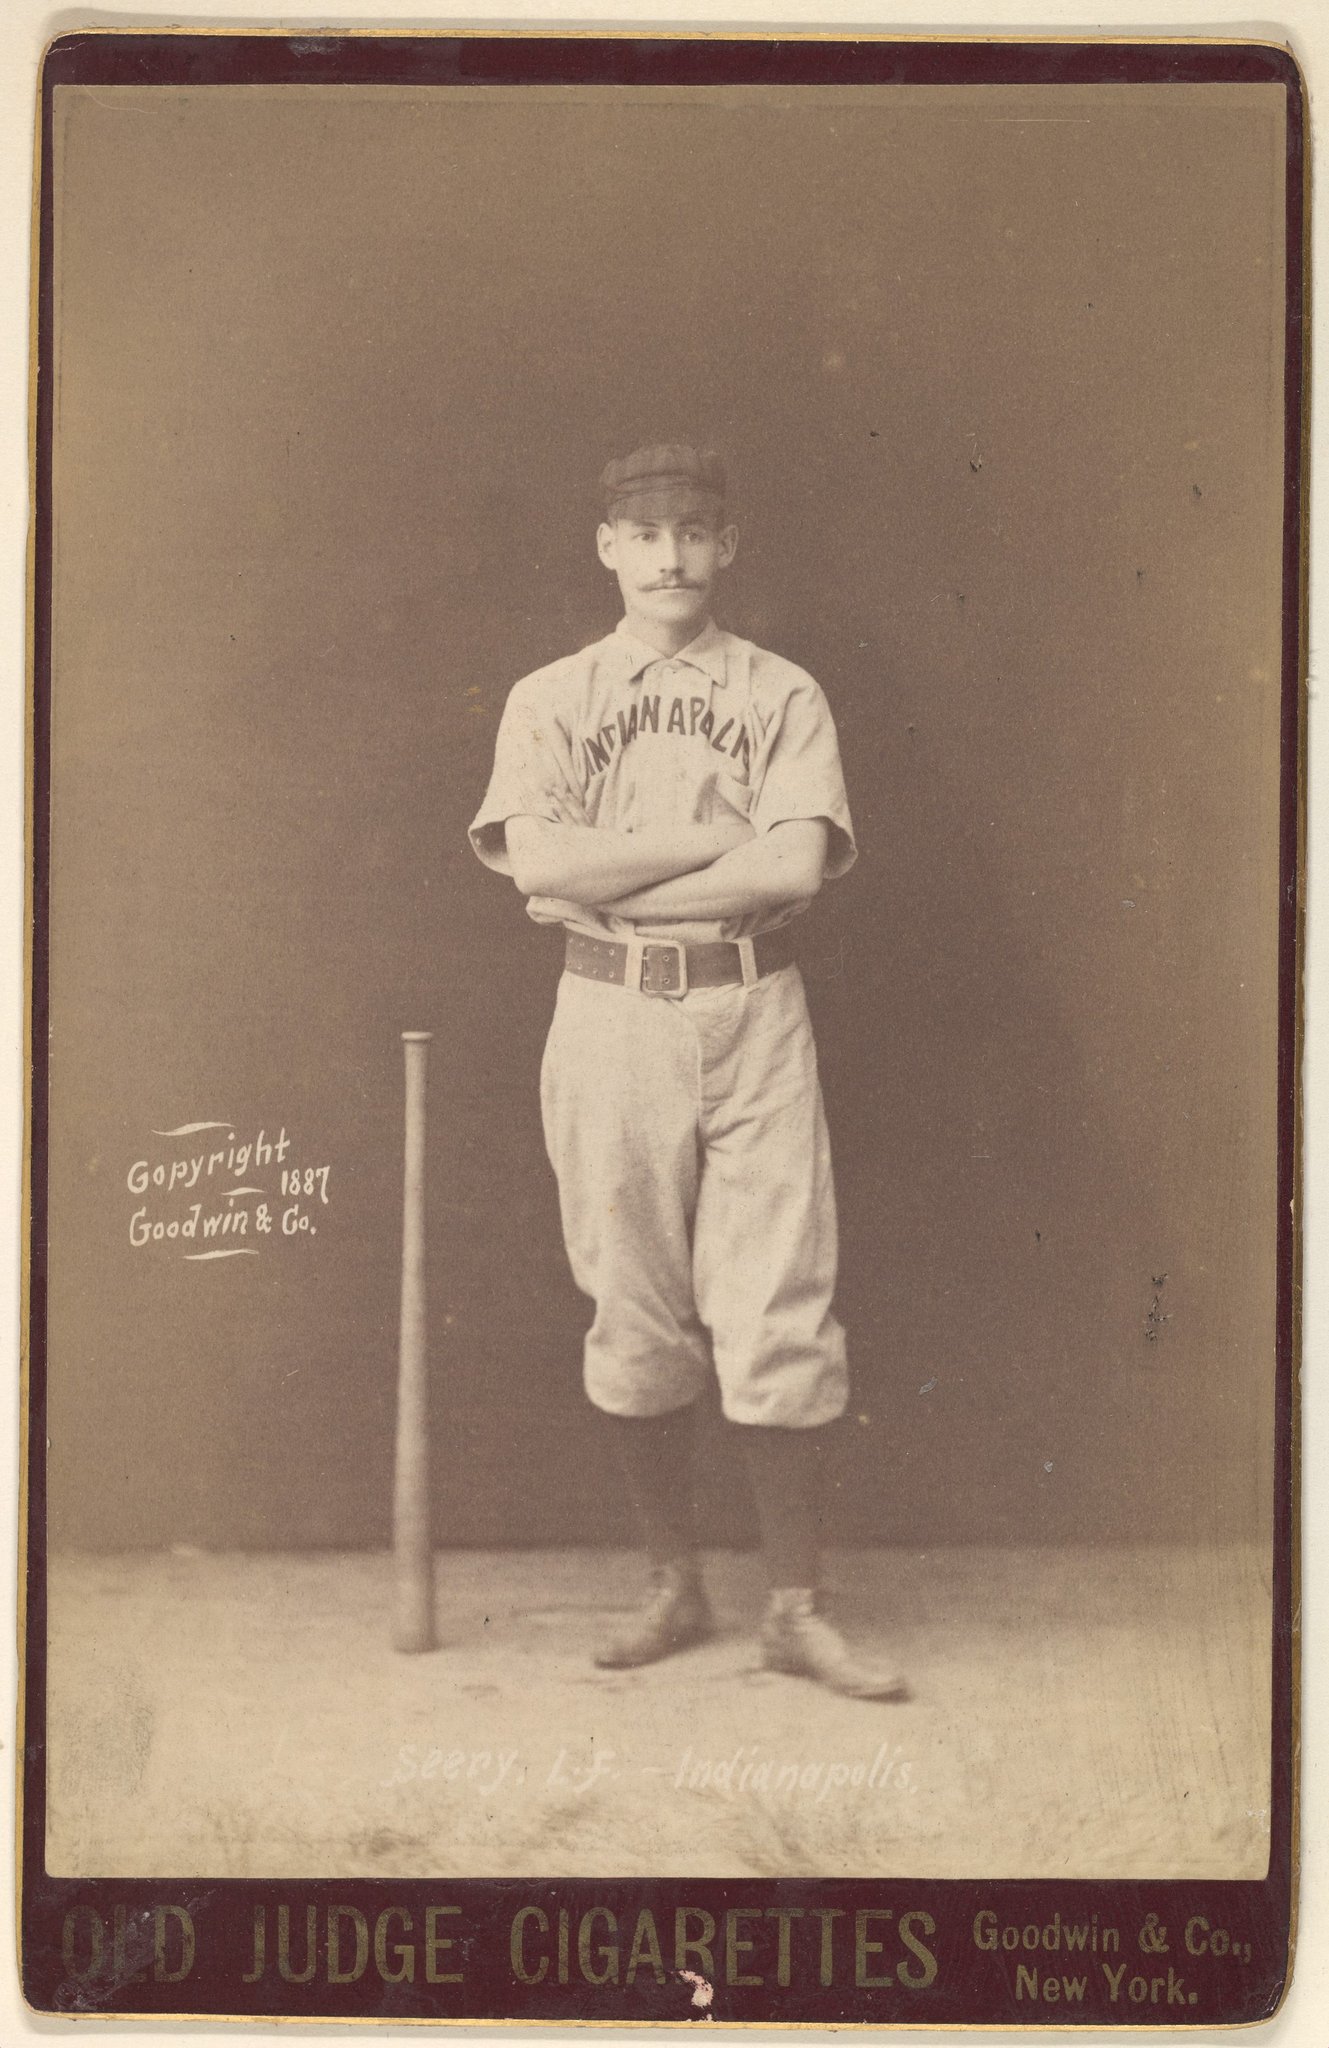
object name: baseball card, photograph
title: Seery, Left Field, Indianapolis, from the series Old Judge Cigarettes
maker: goodwin & company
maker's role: publisher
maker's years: 1850-1950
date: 1887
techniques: albumen silver print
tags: men,portraits,baseball,athletes